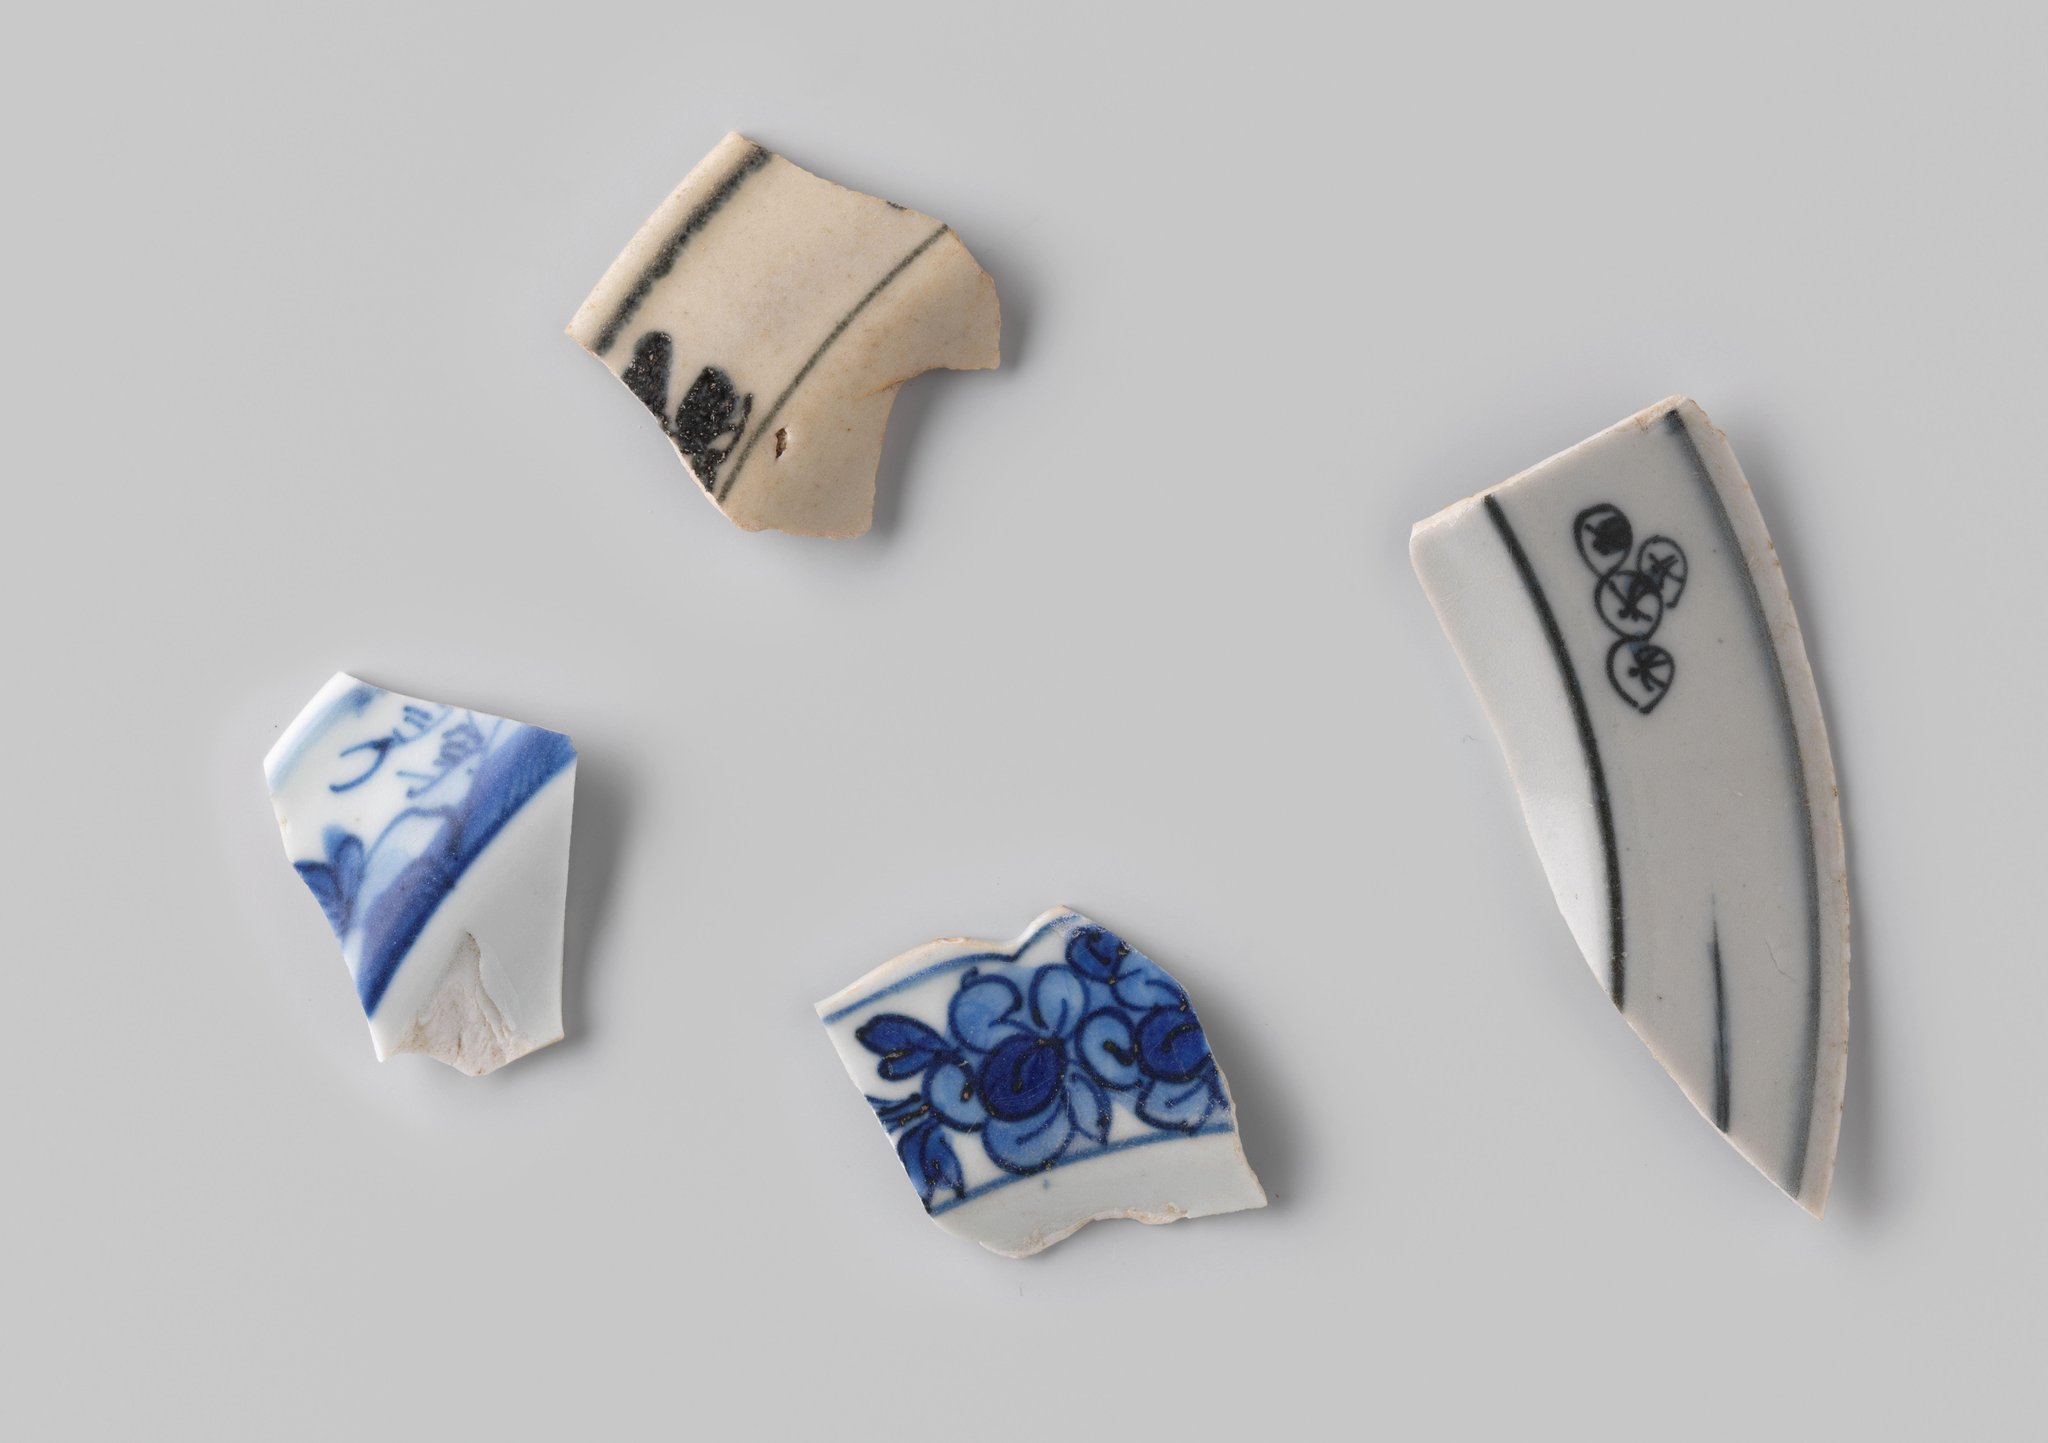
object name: plate dish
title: Scherven van borden uit V.O.C.-schip de 'Witte Leeuw'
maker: Anonymous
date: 1613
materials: porcelain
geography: jingdezhen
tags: verenigde oostindische compagnie, sint-helena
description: A base sherd. In the centre part of a shrimp (?) is visible. On the base part of a 4-character mark: fu kuei...